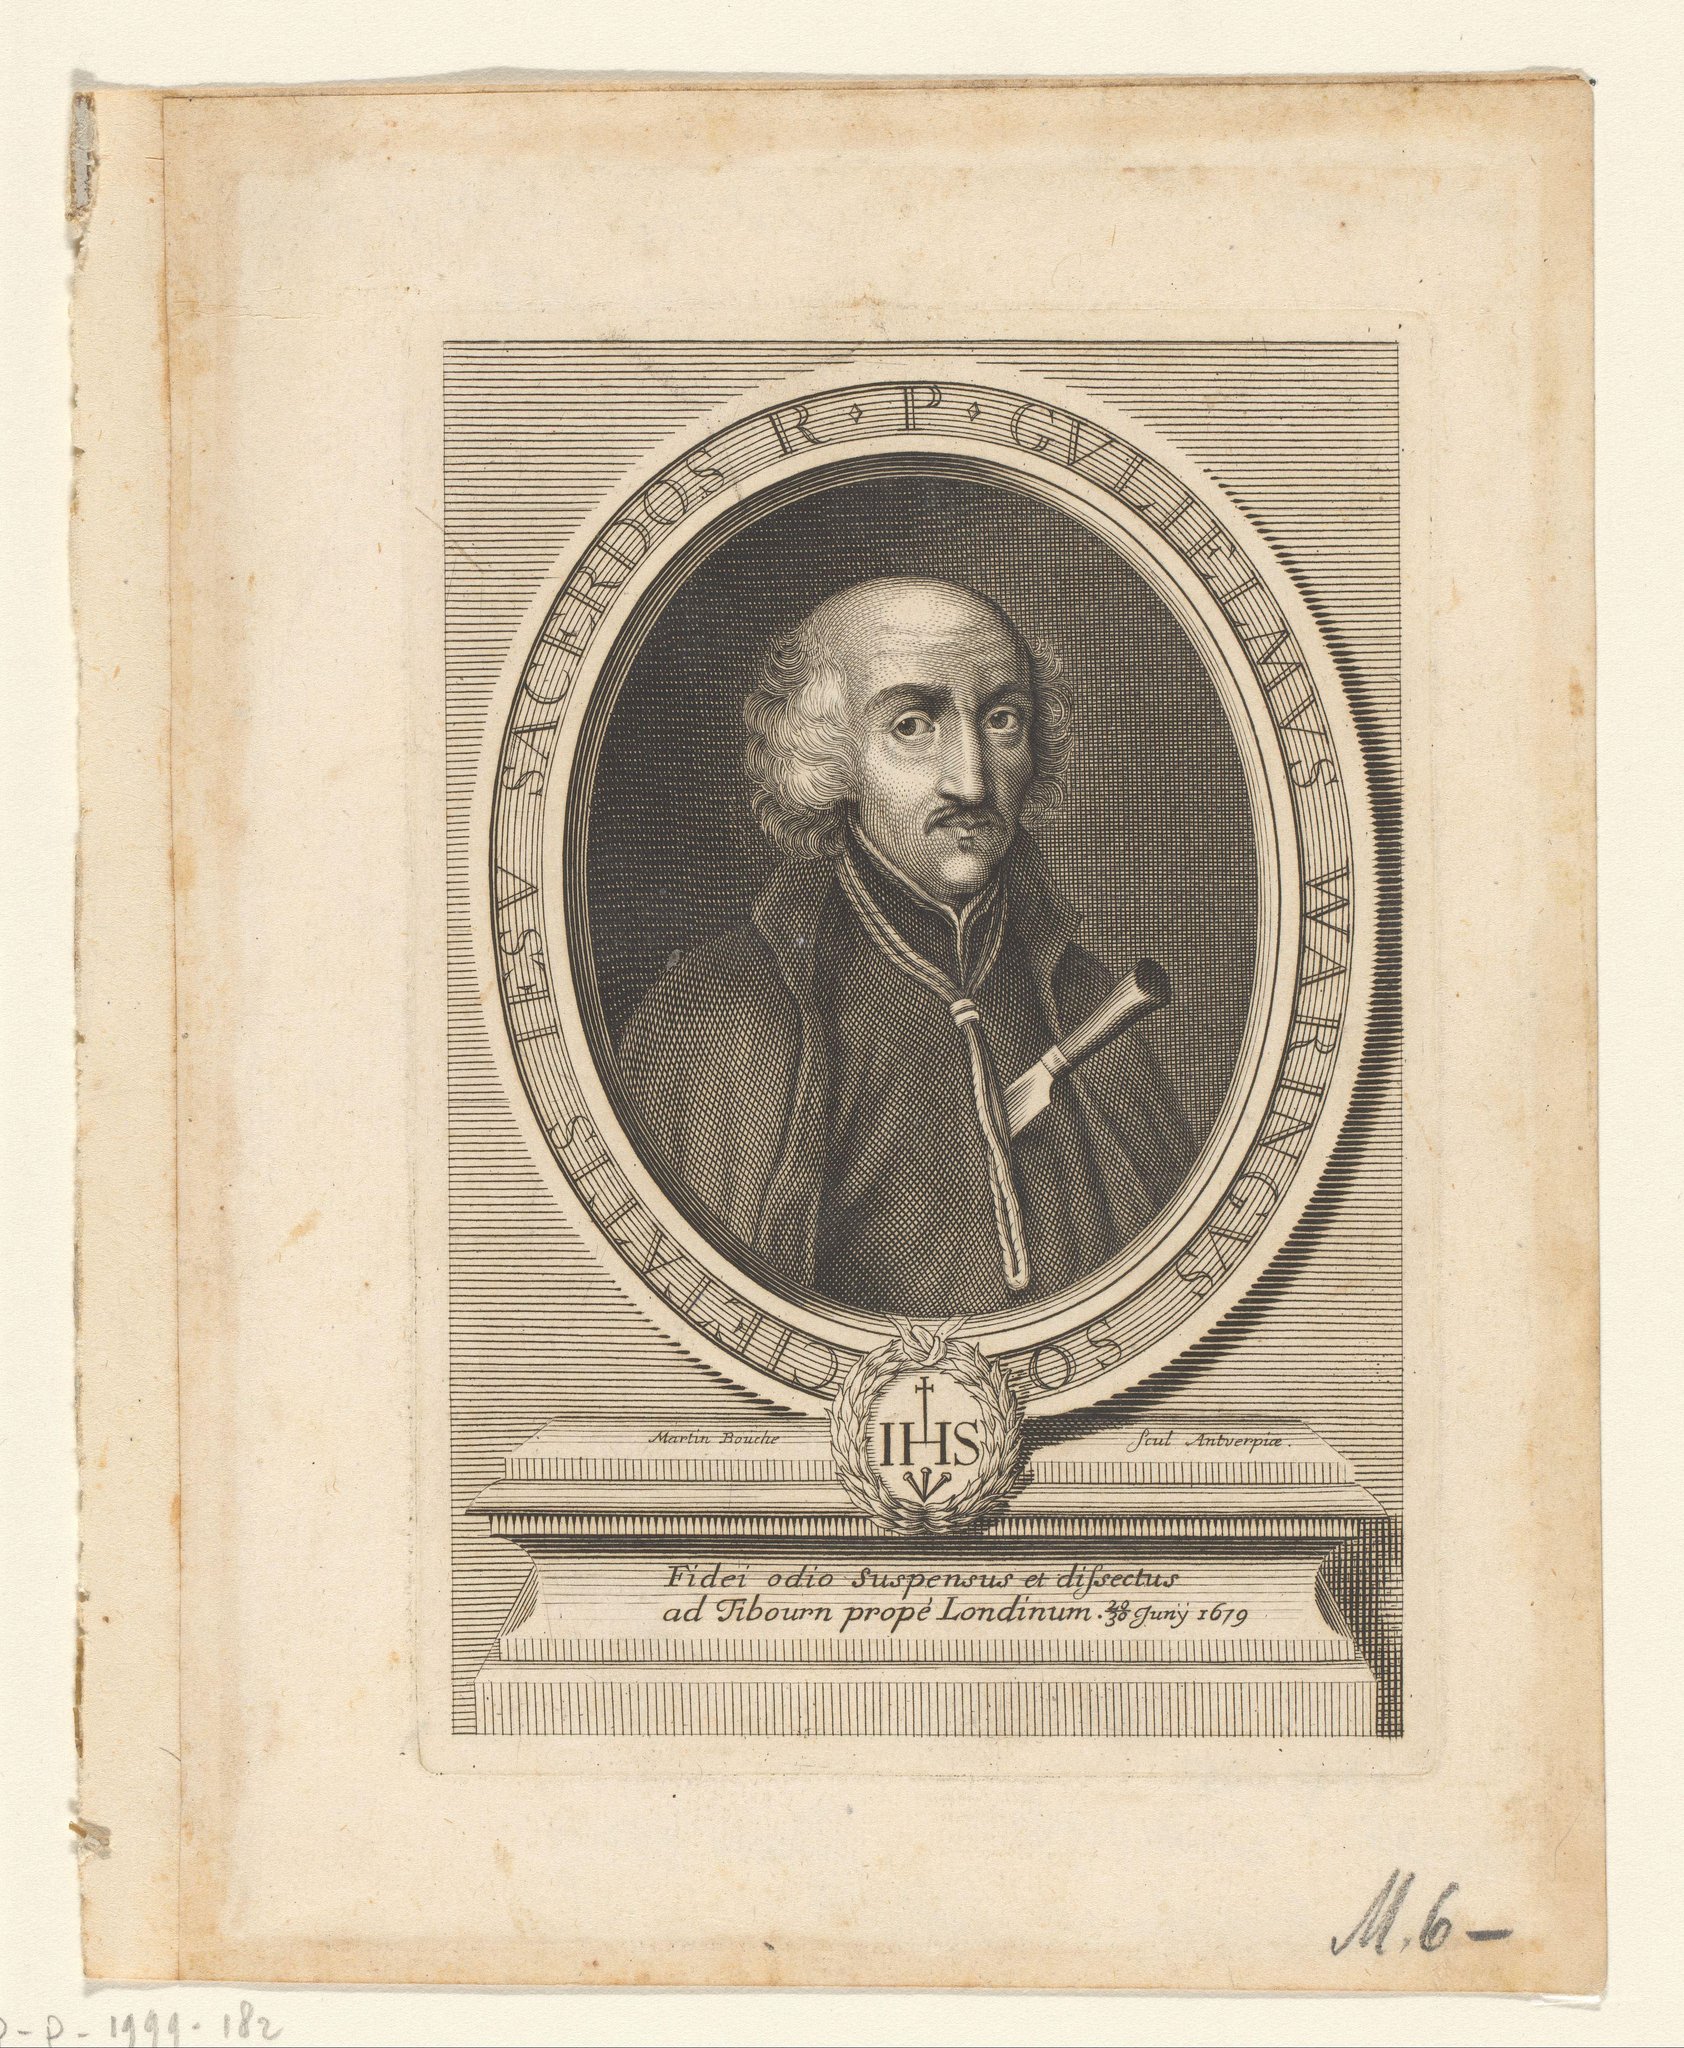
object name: print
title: Portret Guglielmus Waringus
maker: martin bouche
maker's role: print maker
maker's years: 1640-1693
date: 1679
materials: paper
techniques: engraving